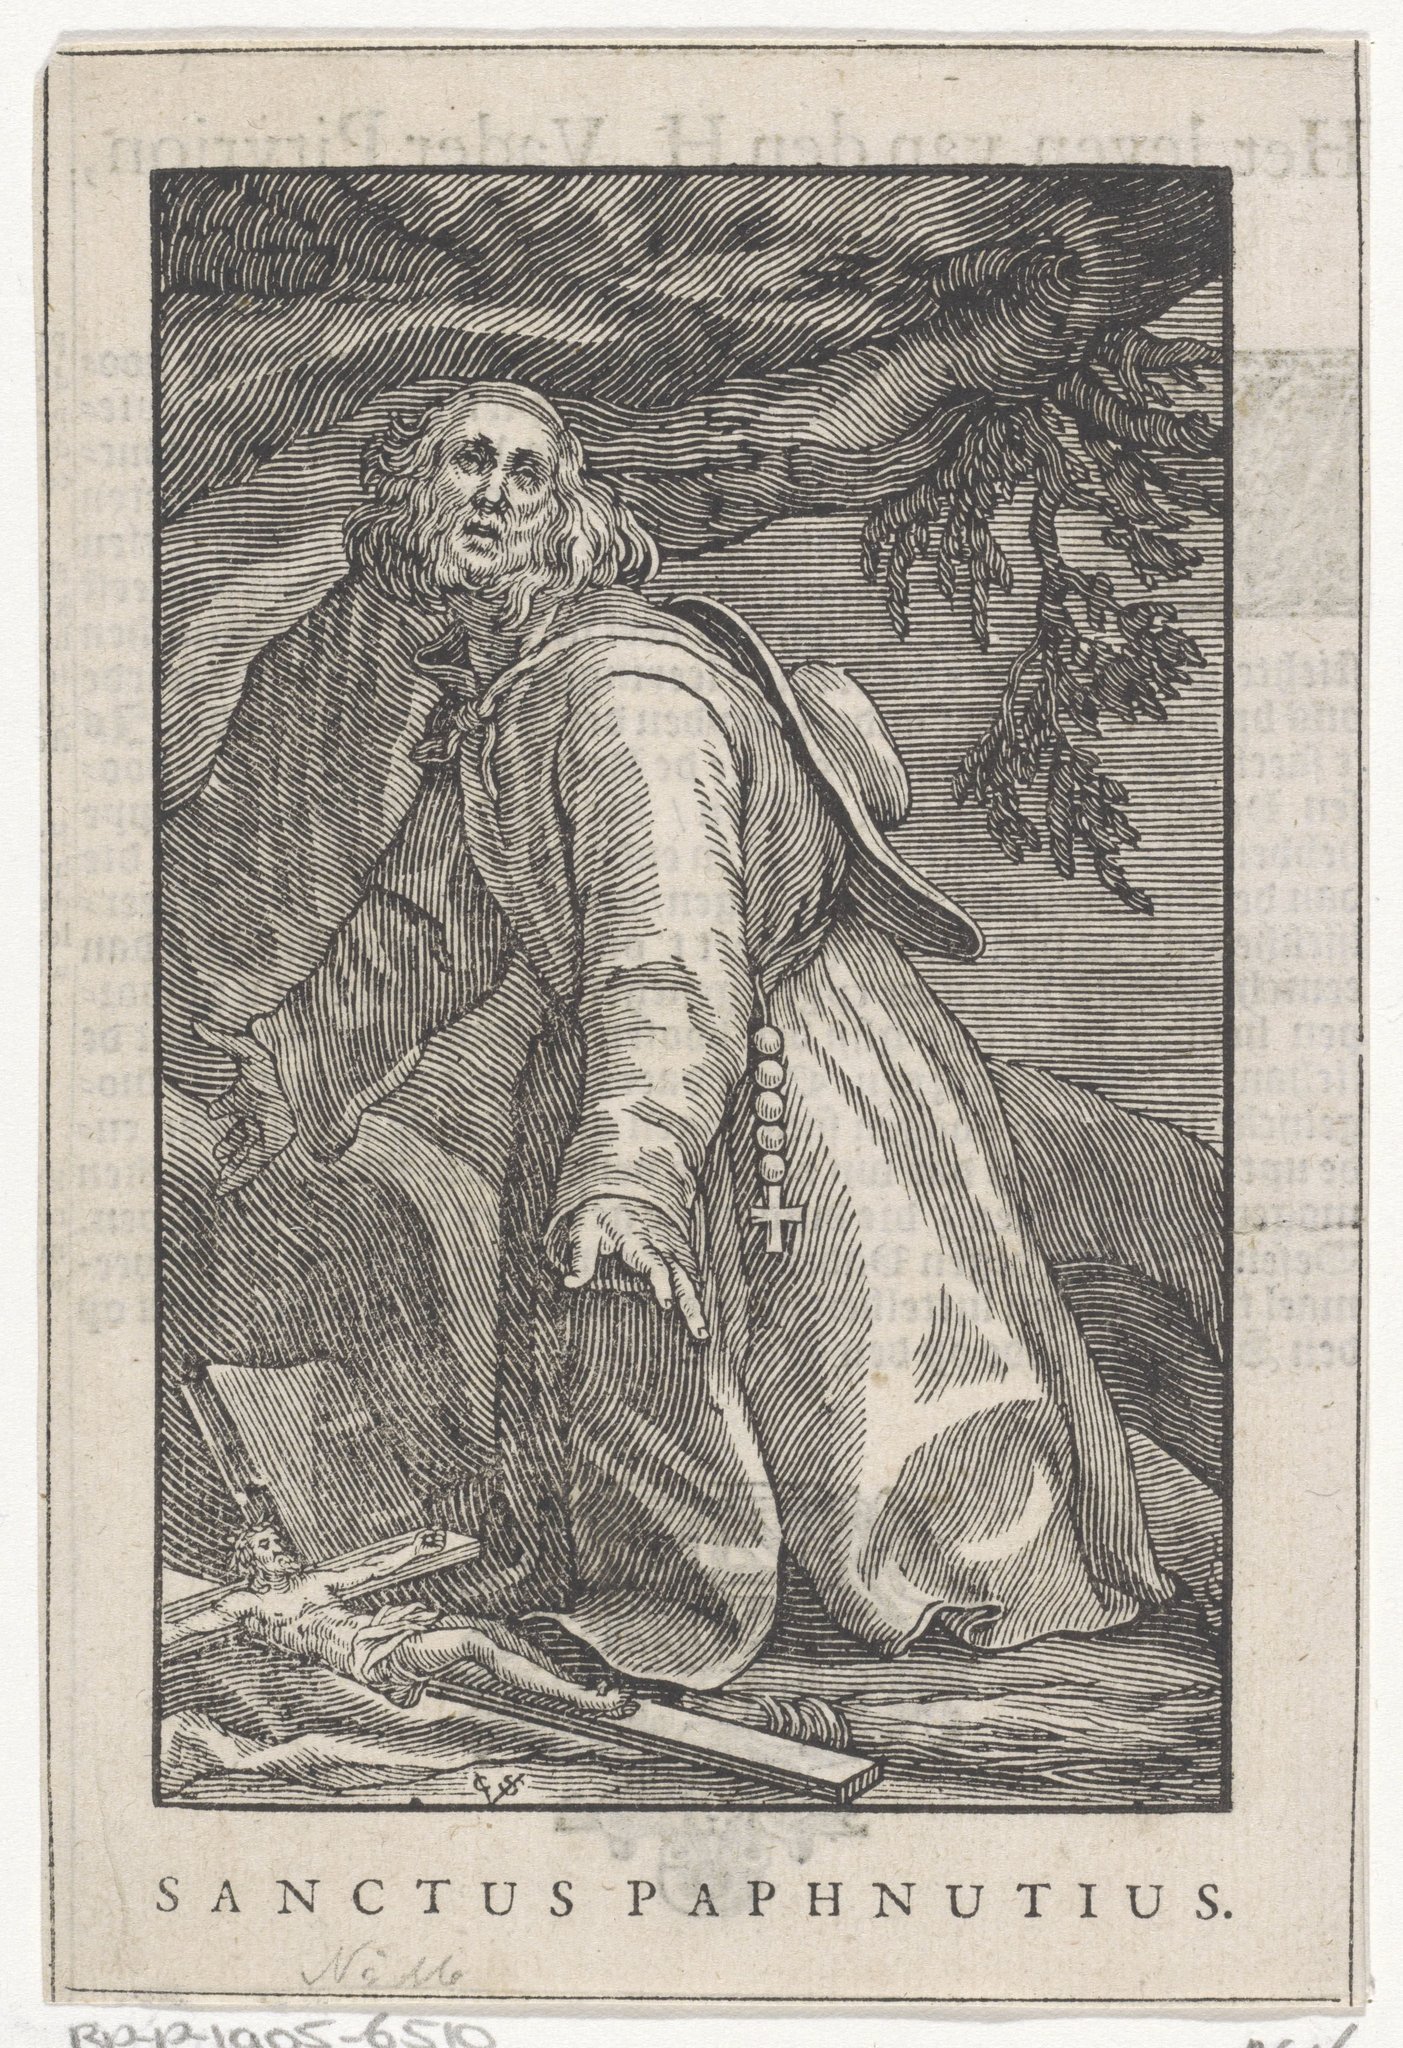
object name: book illustration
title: Heilige Paphnutius als kluizenaar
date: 1644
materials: paper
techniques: letterpress printing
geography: amsterdam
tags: anchorite, hermit, male saints (with name)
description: Prent uit: Rosweyde, Heribert. 'tBosch der eremyten ende eremitinnen, van Aegypten ende Palestinen. Amsterdam: Pieter Jacobsz. Paets, 1644.